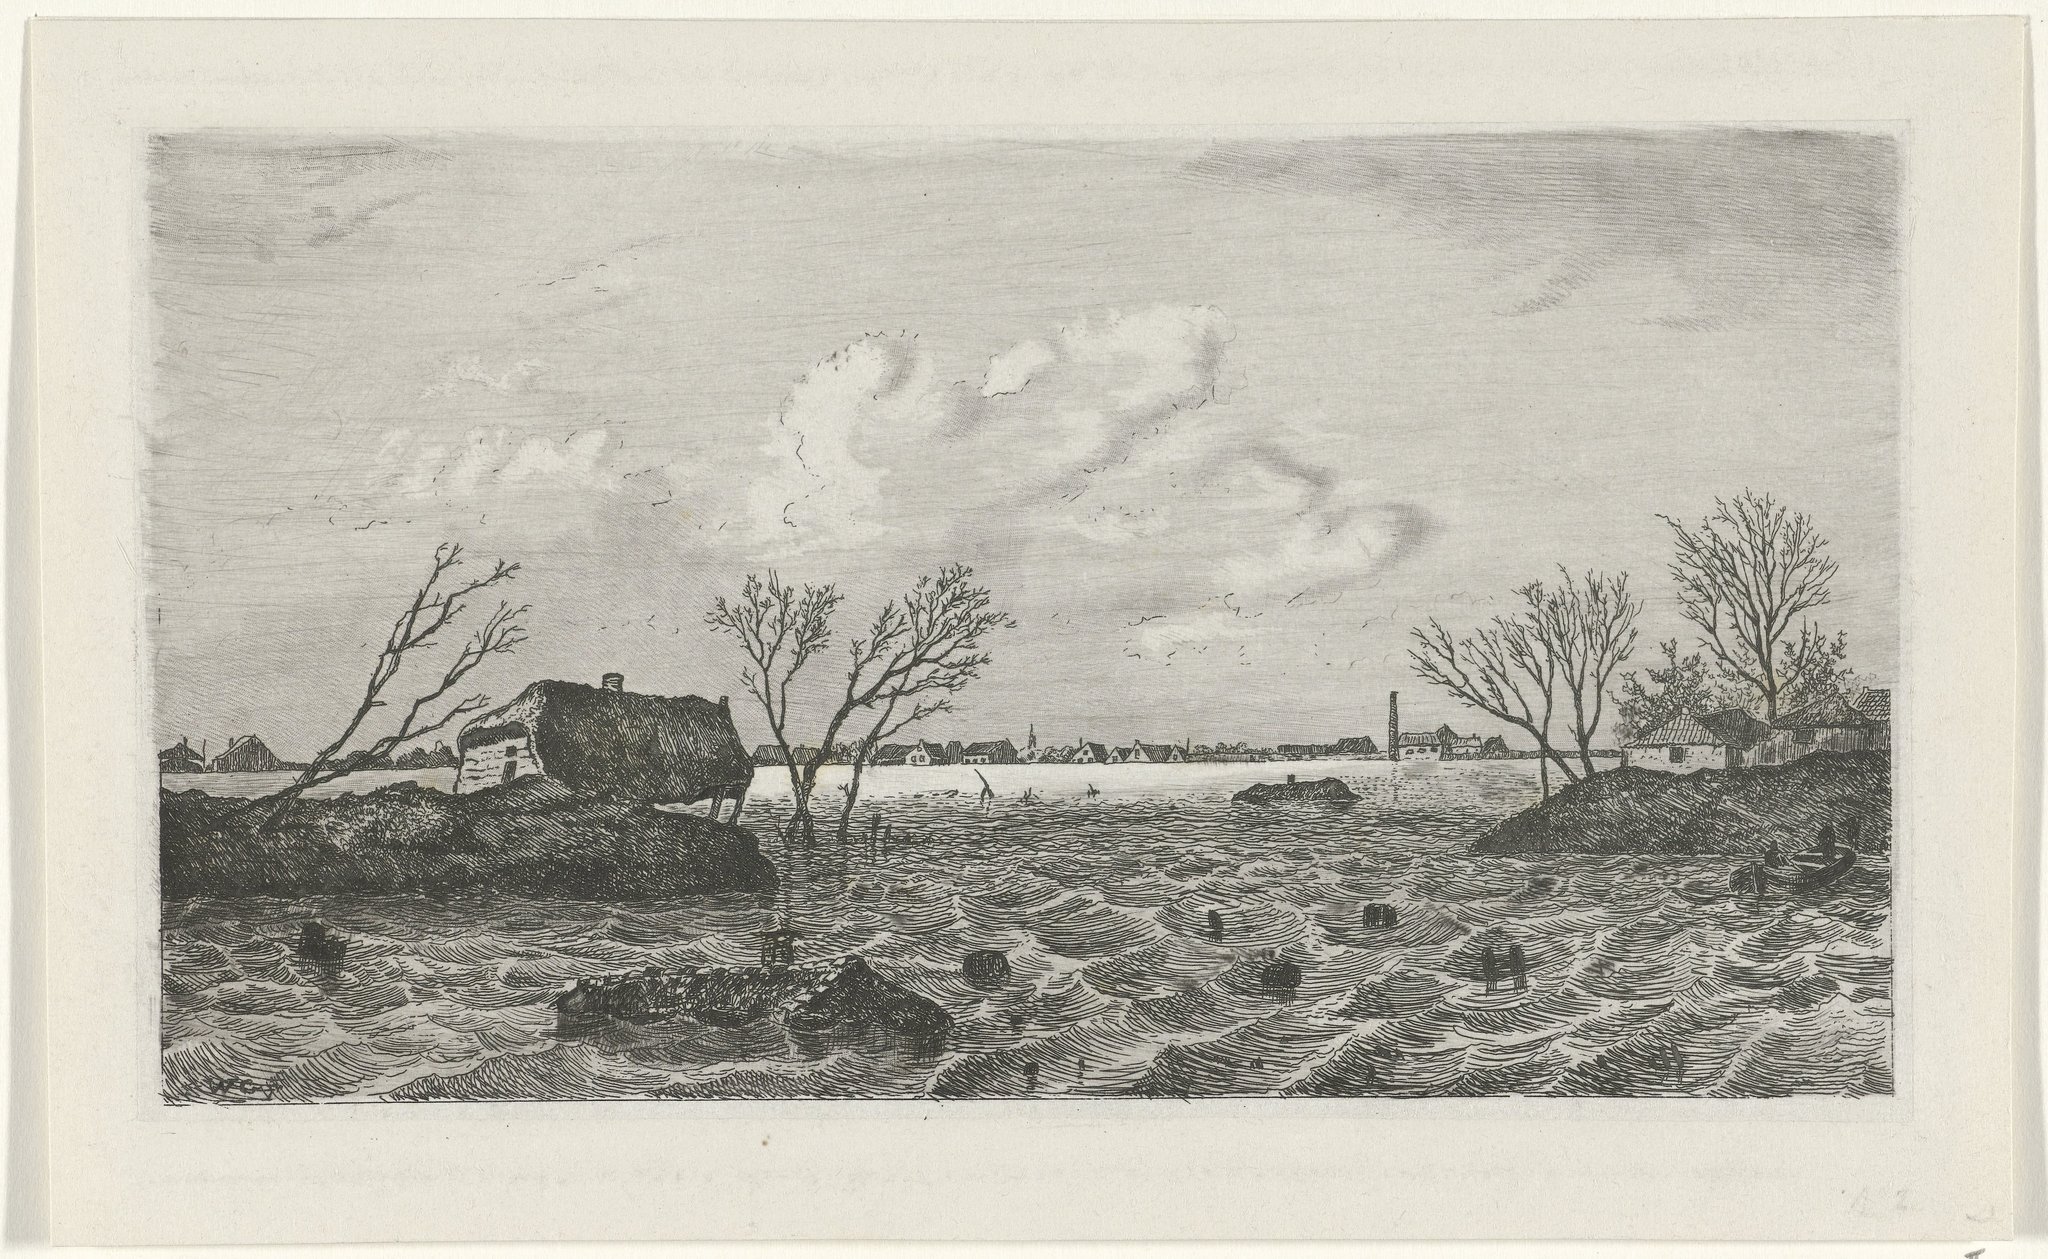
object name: print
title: Dijkdoorbraak bij Dreumel, 1855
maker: willem gruyter jr.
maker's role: draughtsman, print maker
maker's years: 1817-1880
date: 1832-1880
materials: paper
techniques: aquatint, etching, roulette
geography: amsterdam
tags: dike-break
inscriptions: collector's mark: Lugt 2228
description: Landschap met dijkdoorbraak bij Dreumel tijdens de watersnoodramp in 1855.